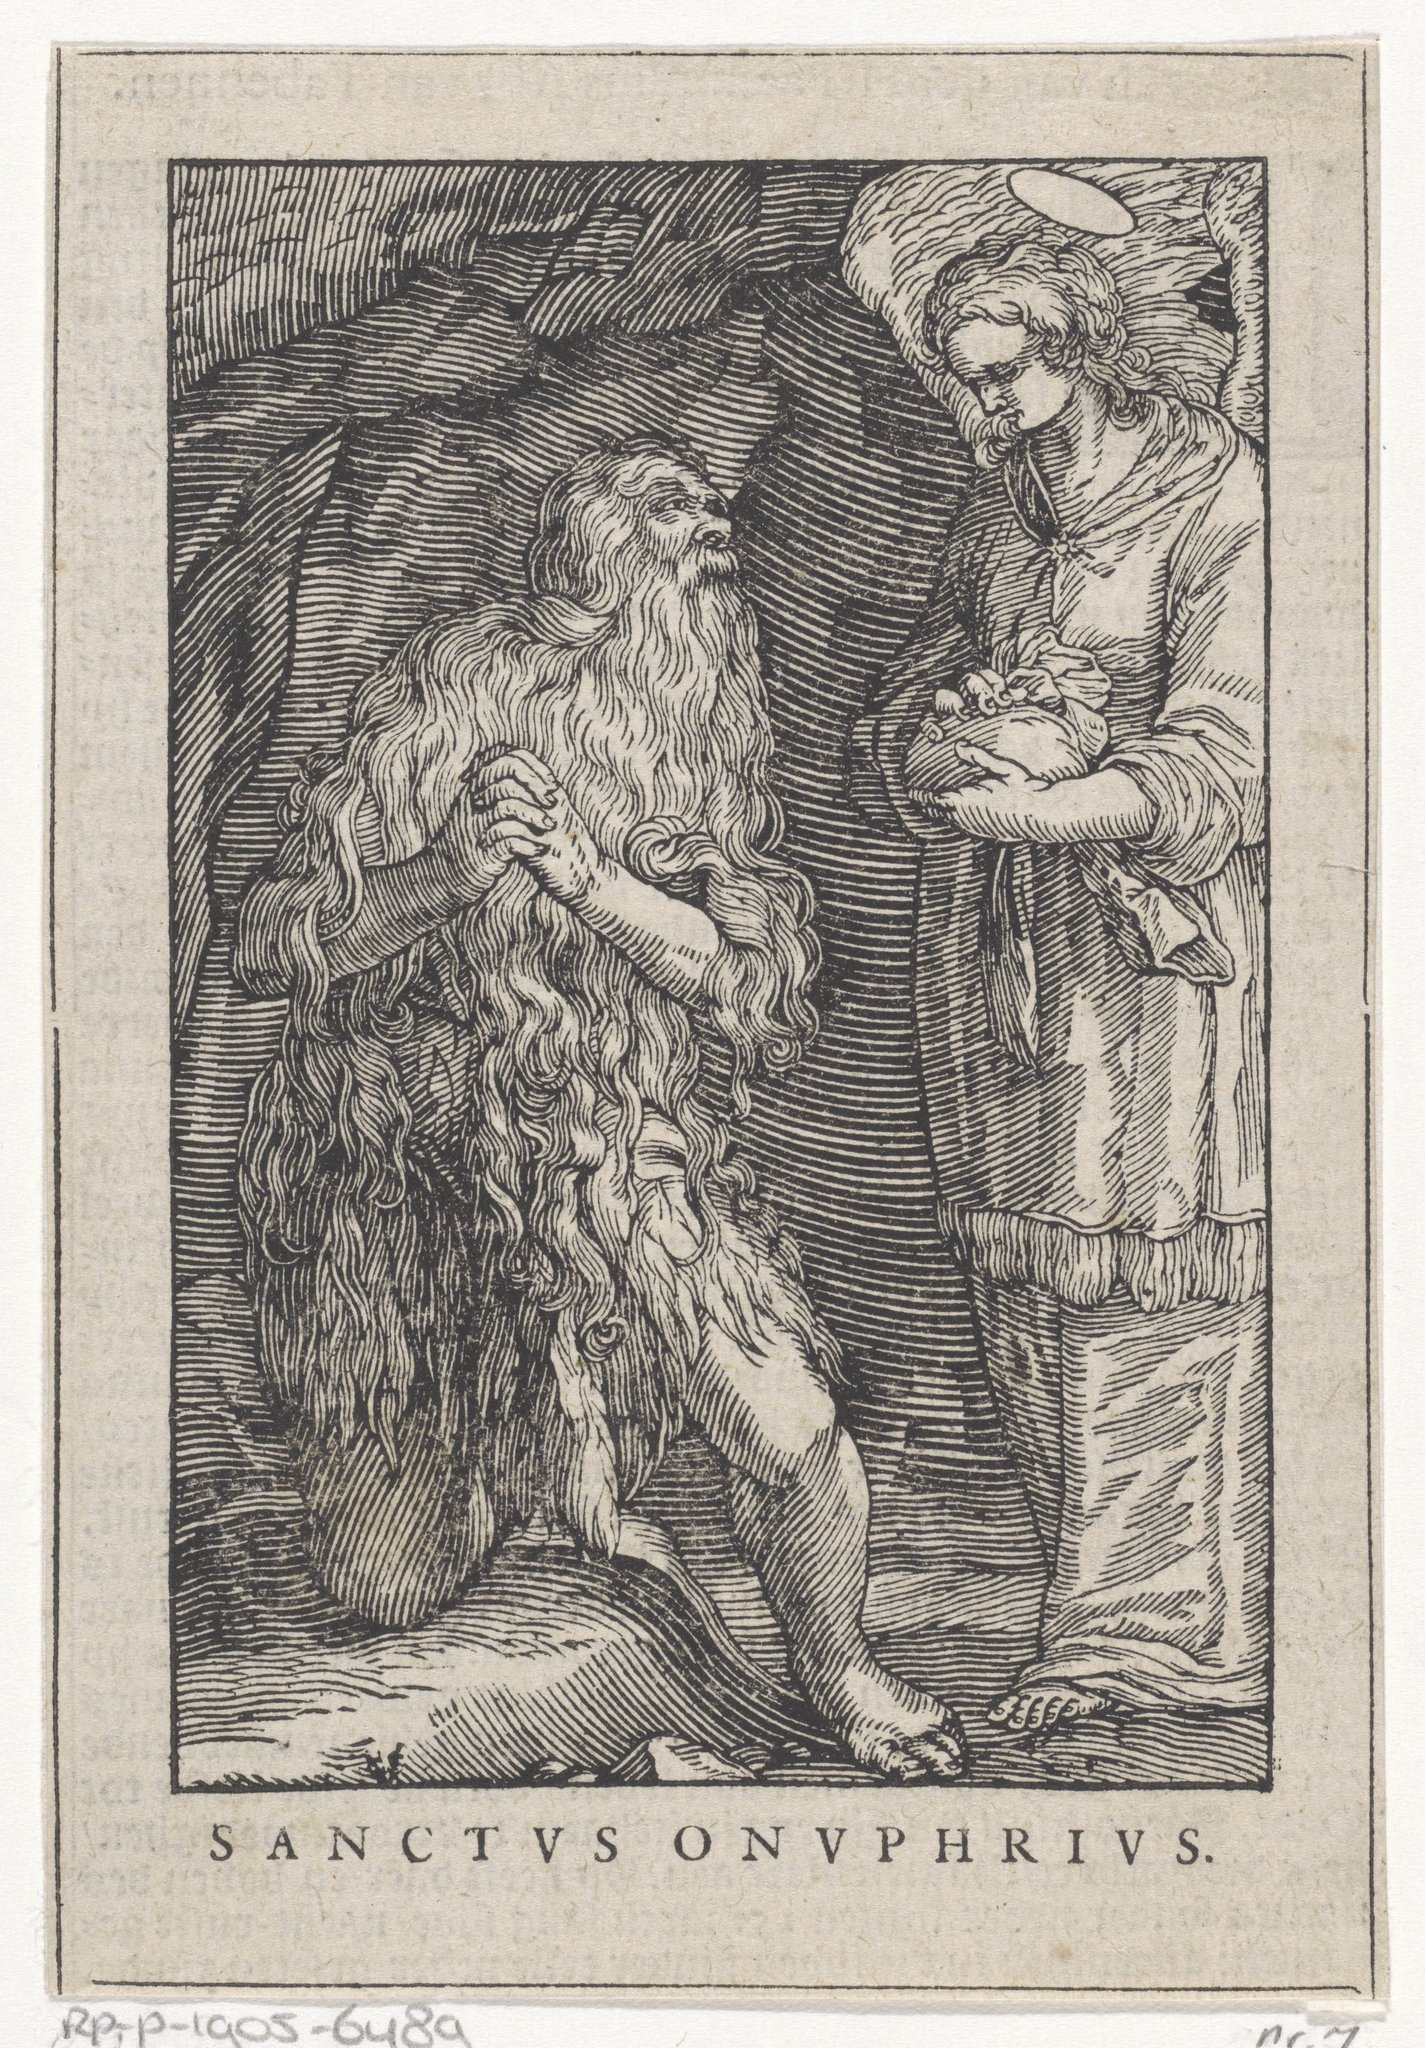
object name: print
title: Heilige Onyphrius de Grote als kluizenaar met engel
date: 1644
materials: paper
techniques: letterpress printing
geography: amsterdam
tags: male saints (with name), anchorite, hermit, angels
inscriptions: collector's mark: Lugt 2228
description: Prent uit: Rosweyde, Heribert. 'tBosch der eremyten ende eremitinnen, van Aegypten ende Palestinen. Amsterdam: Pieter Jacobsz. Paets, 1644.